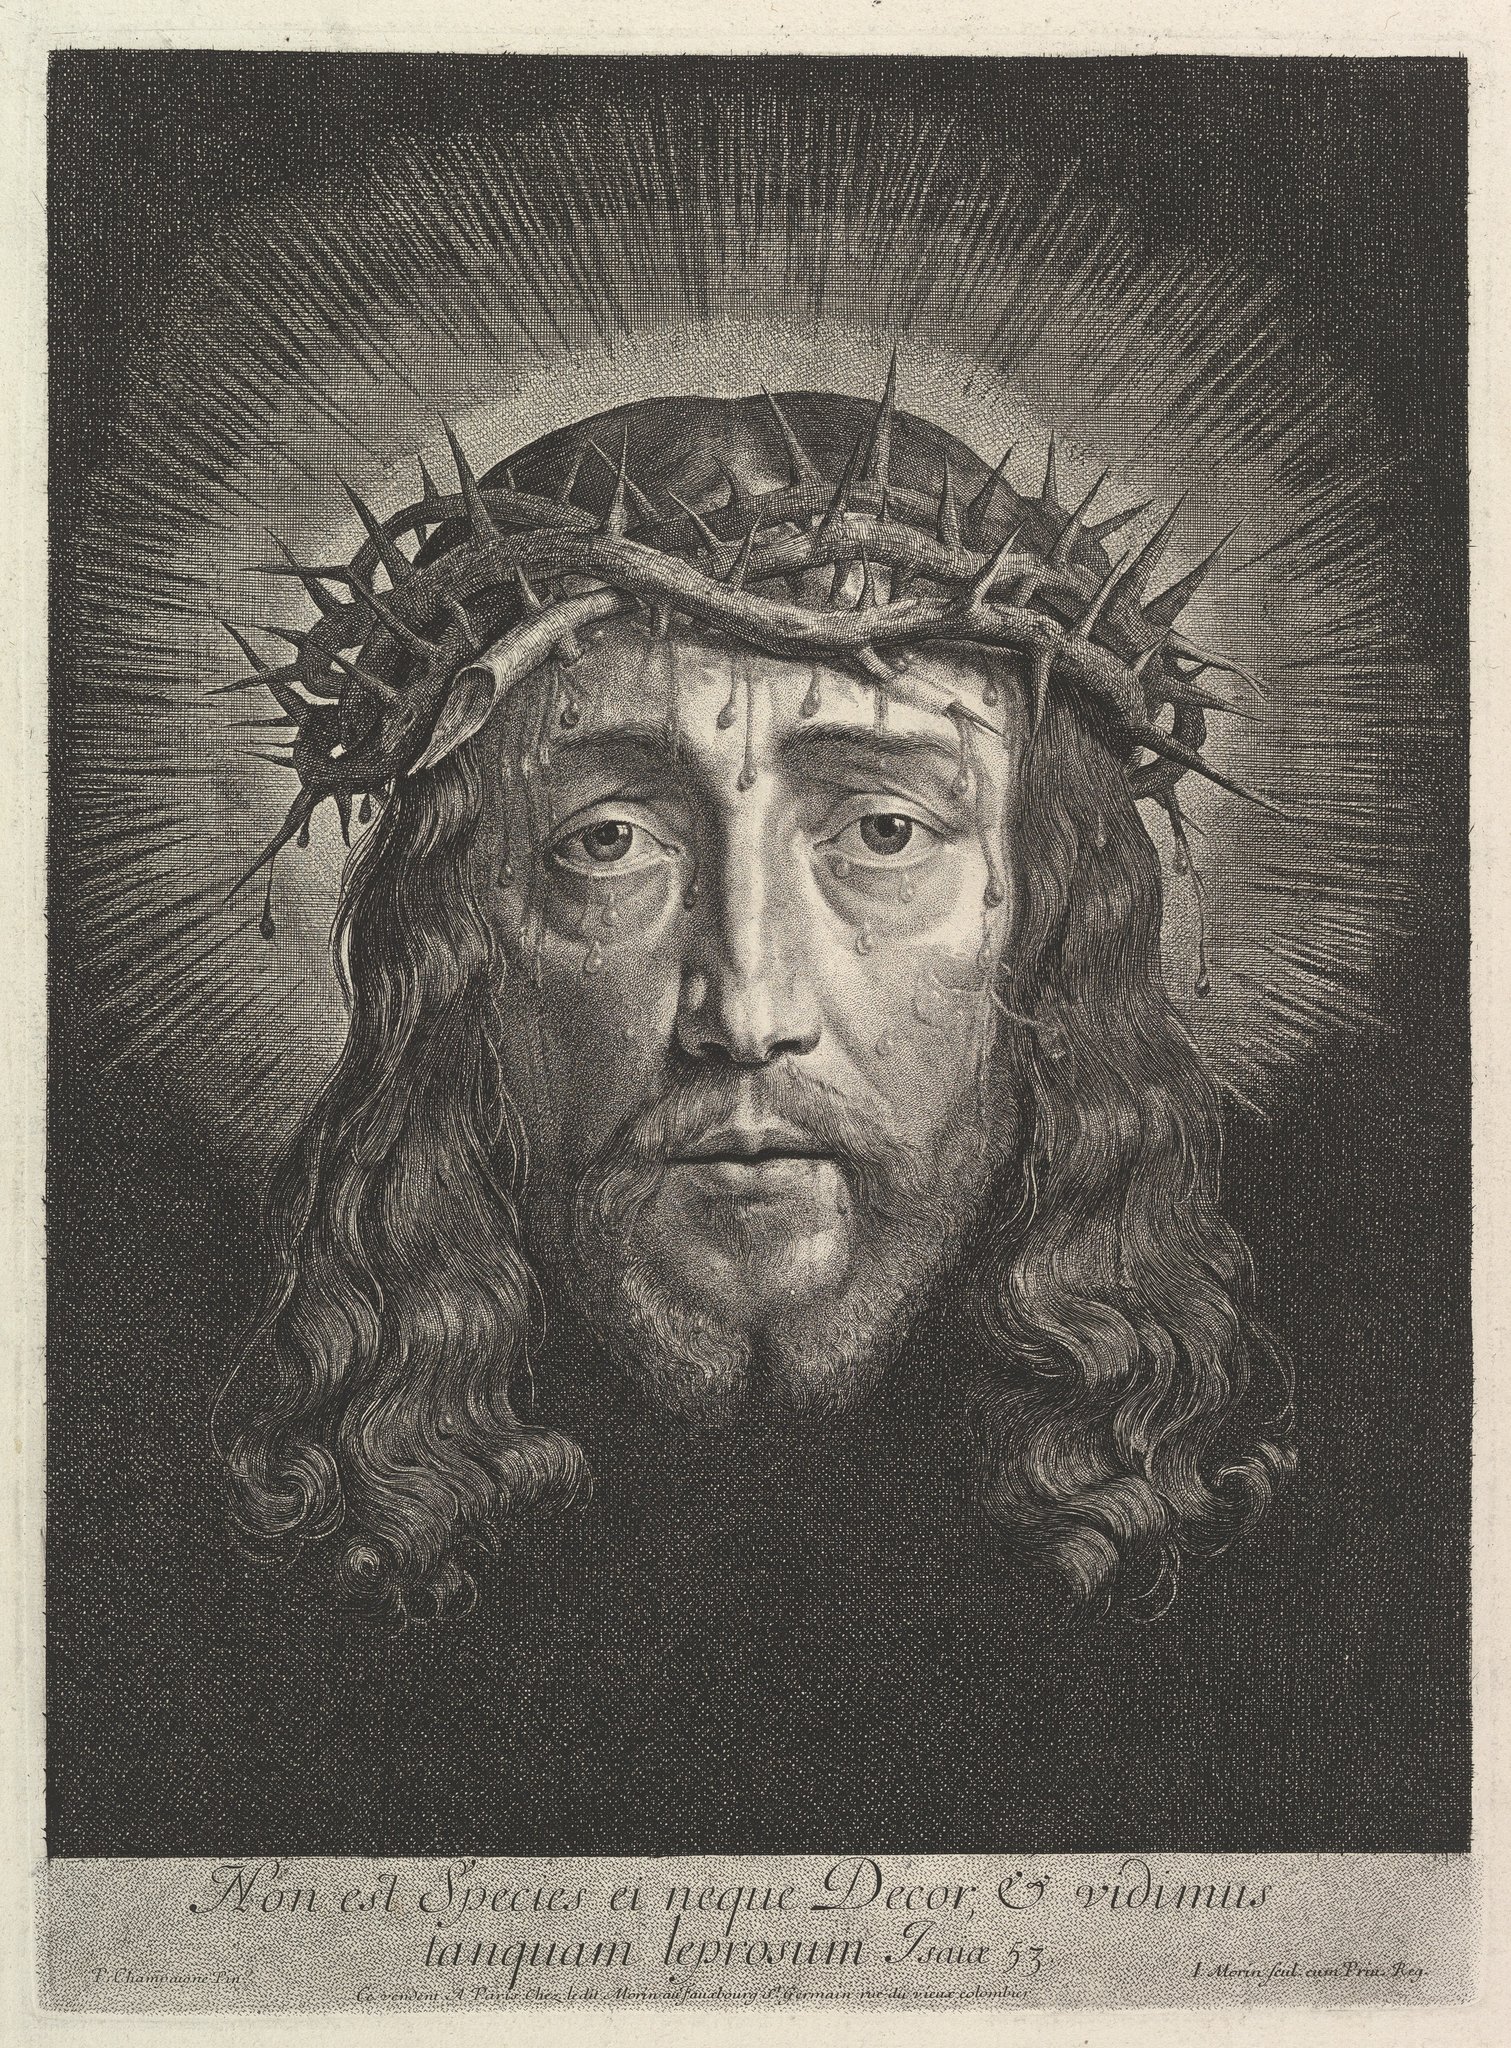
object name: print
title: La sainte Face couronnee d'epines, (grand format)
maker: jean morin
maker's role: artist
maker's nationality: french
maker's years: 1605-1650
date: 1605-1650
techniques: etching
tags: jesus